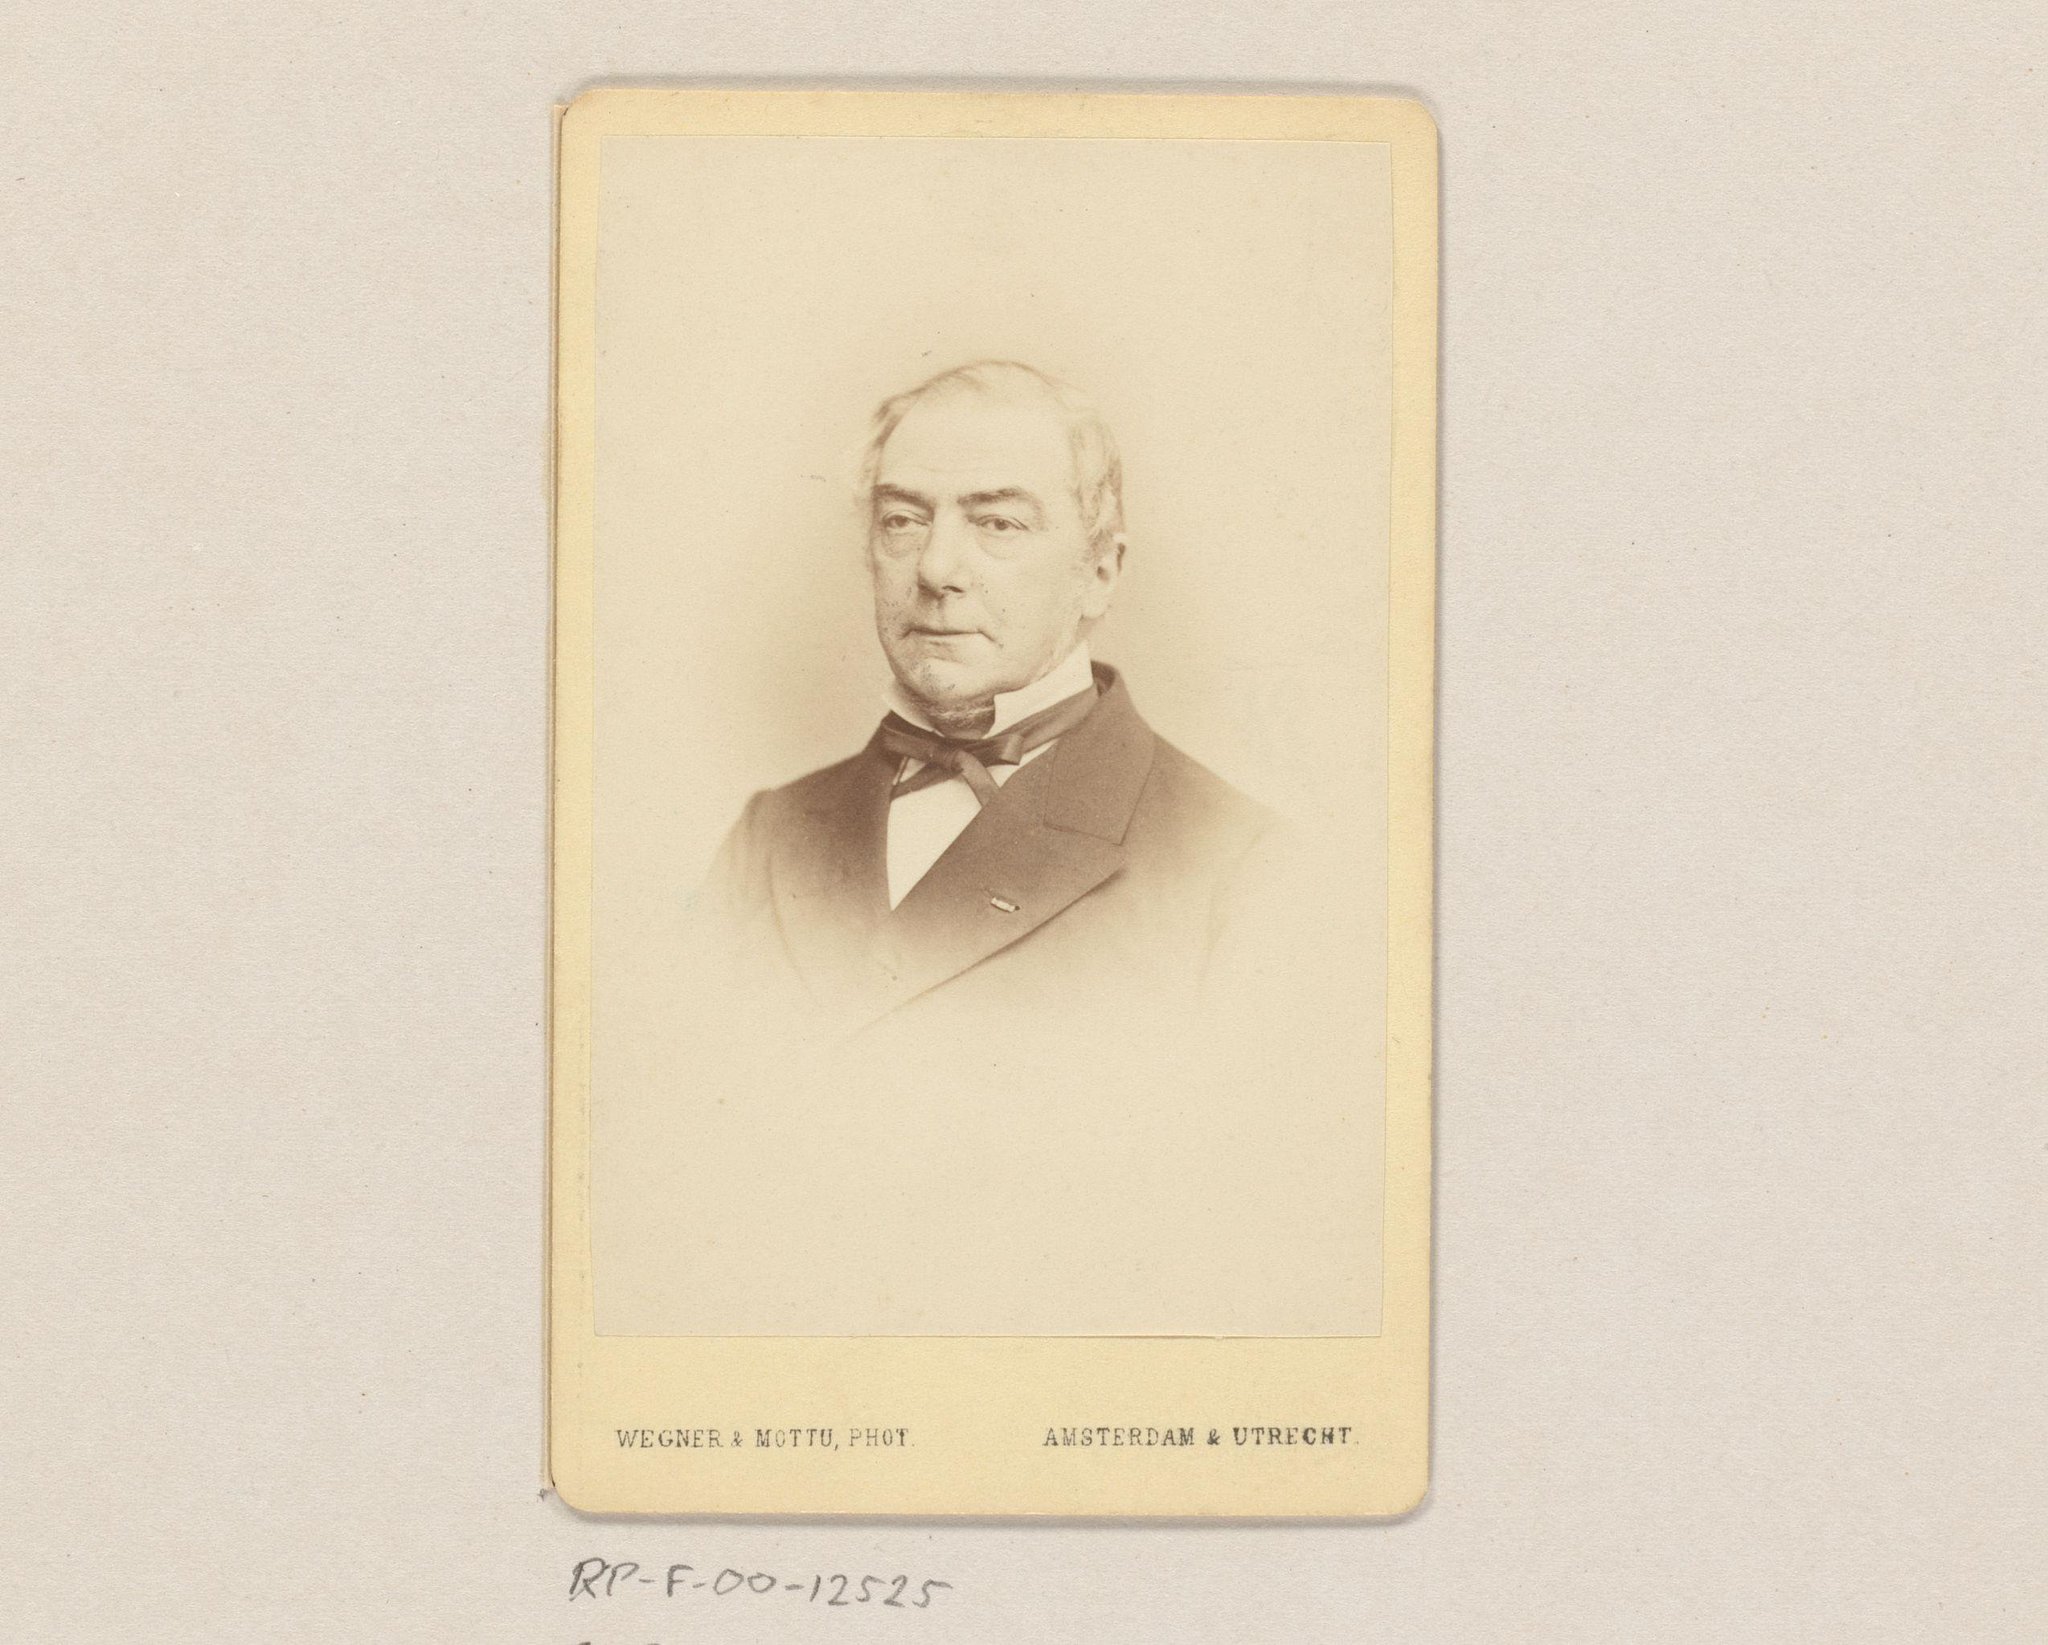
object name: carte de visite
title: Portret van Willem Mees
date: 1867-1875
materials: cardboard, paper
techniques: albumen print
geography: amsterdam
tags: rotterdam, amsterdam, historical persons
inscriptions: address: ‘KALVERSTRAAT/ over den Heyligenweg D 26/ AMSTERDAM/ LEYDSCHE STRAATWEG/ buiten Cathrynen/ UTRECHT’